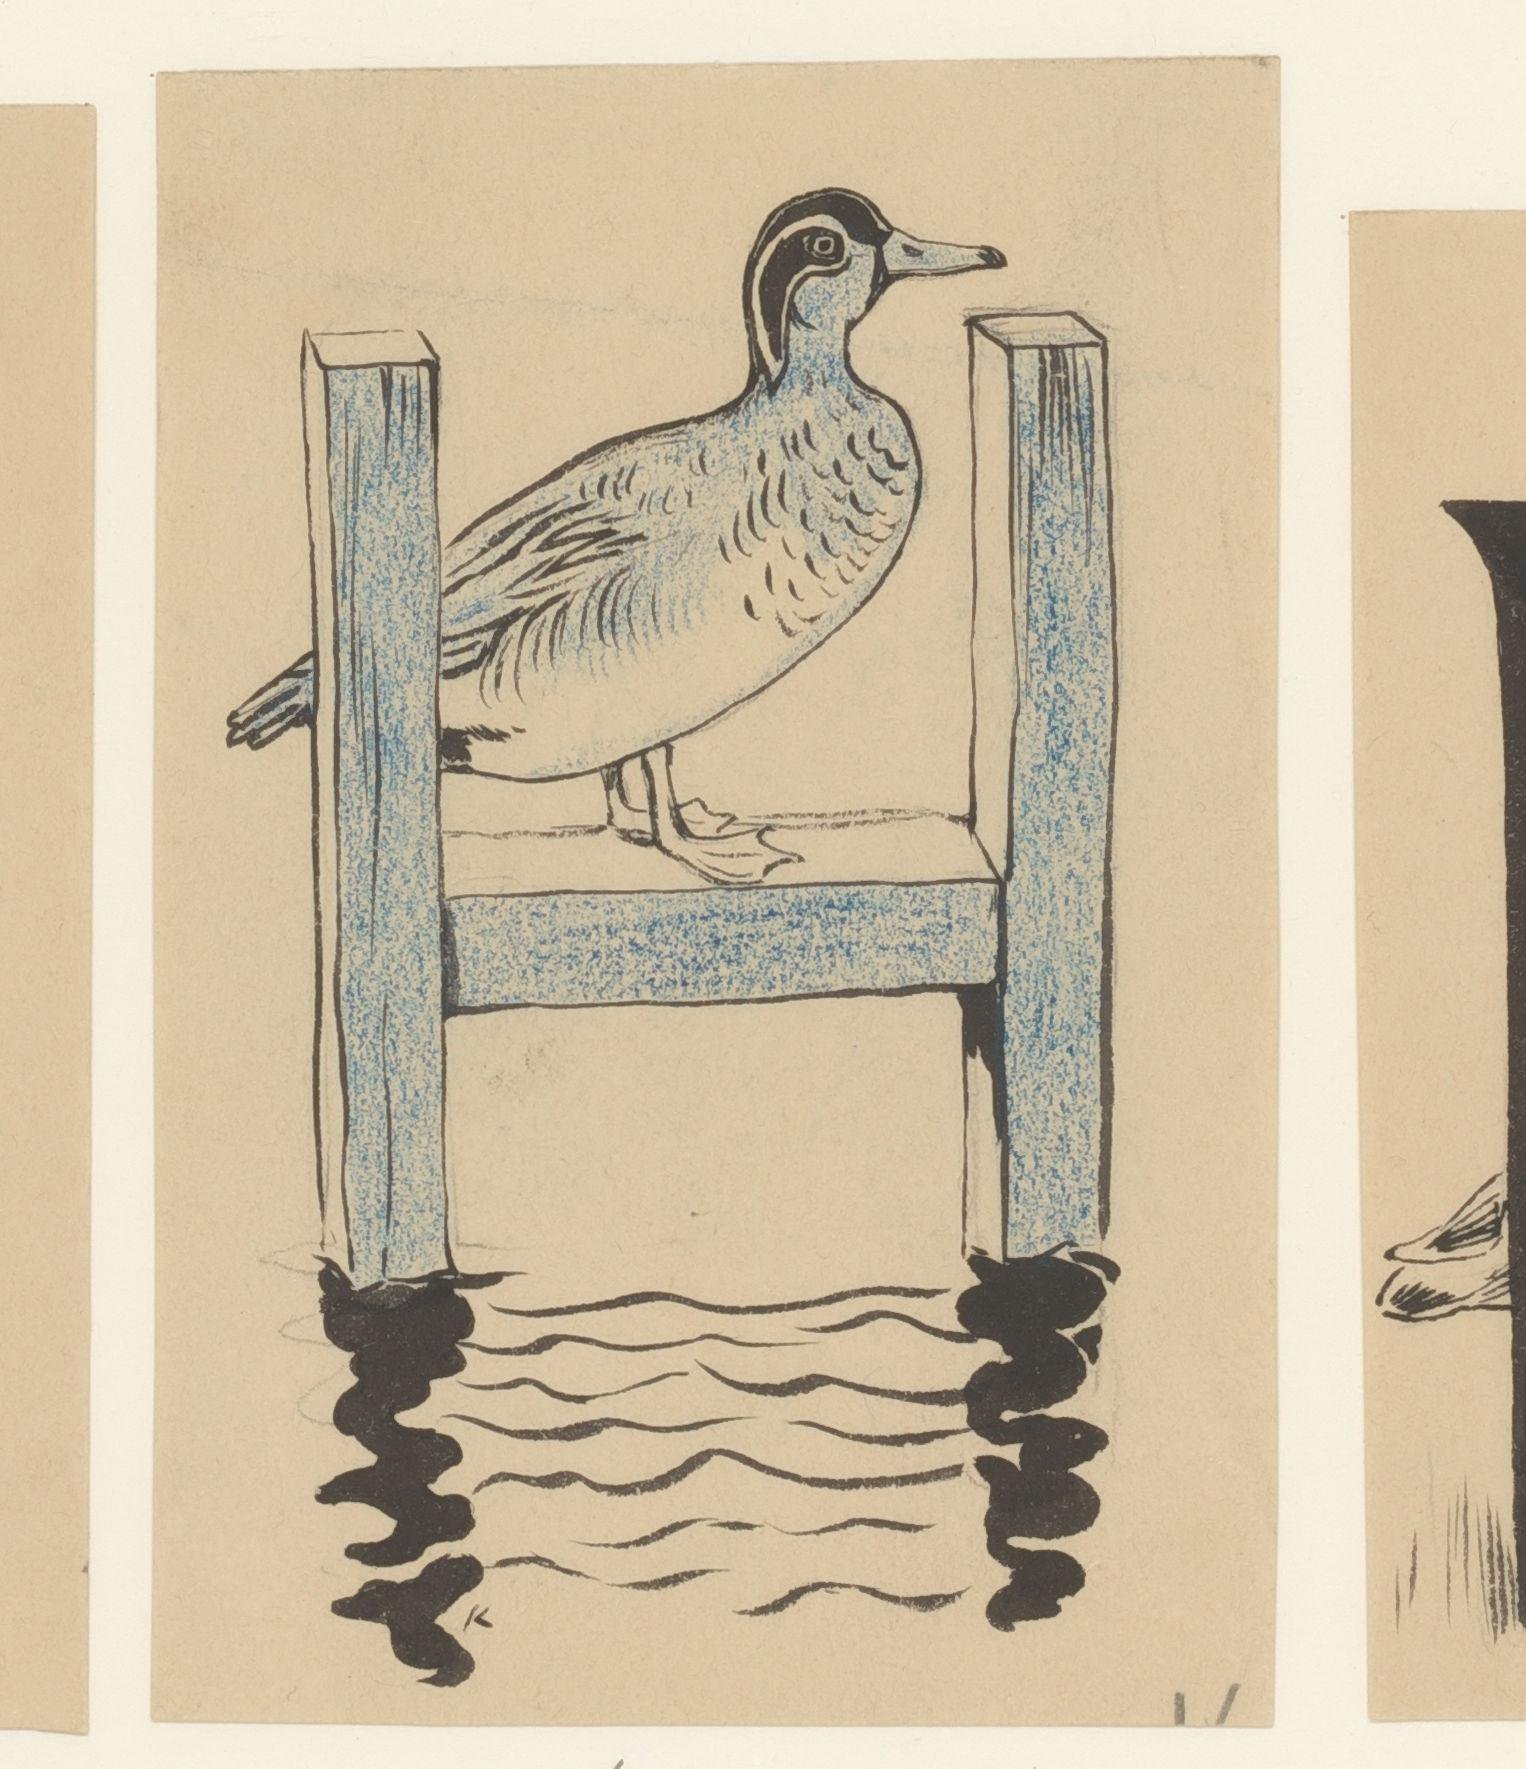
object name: drawing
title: Letter H met eend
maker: heinrich m. krabbé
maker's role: draughtsman, print maker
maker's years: 1868-1931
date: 1899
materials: ink, paper, pencil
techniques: brush, pen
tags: letters, alphabet, script, water-birds: duck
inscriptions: collector's mark: Lugt 1641, stamp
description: Onderwerpsrubrieken binnen de Atlas Zeden en Gewoonten: Handel, Nijverheid en Verkeer, Beroep en bedrijf, Mannelijk, Eet- en drinkwaren.